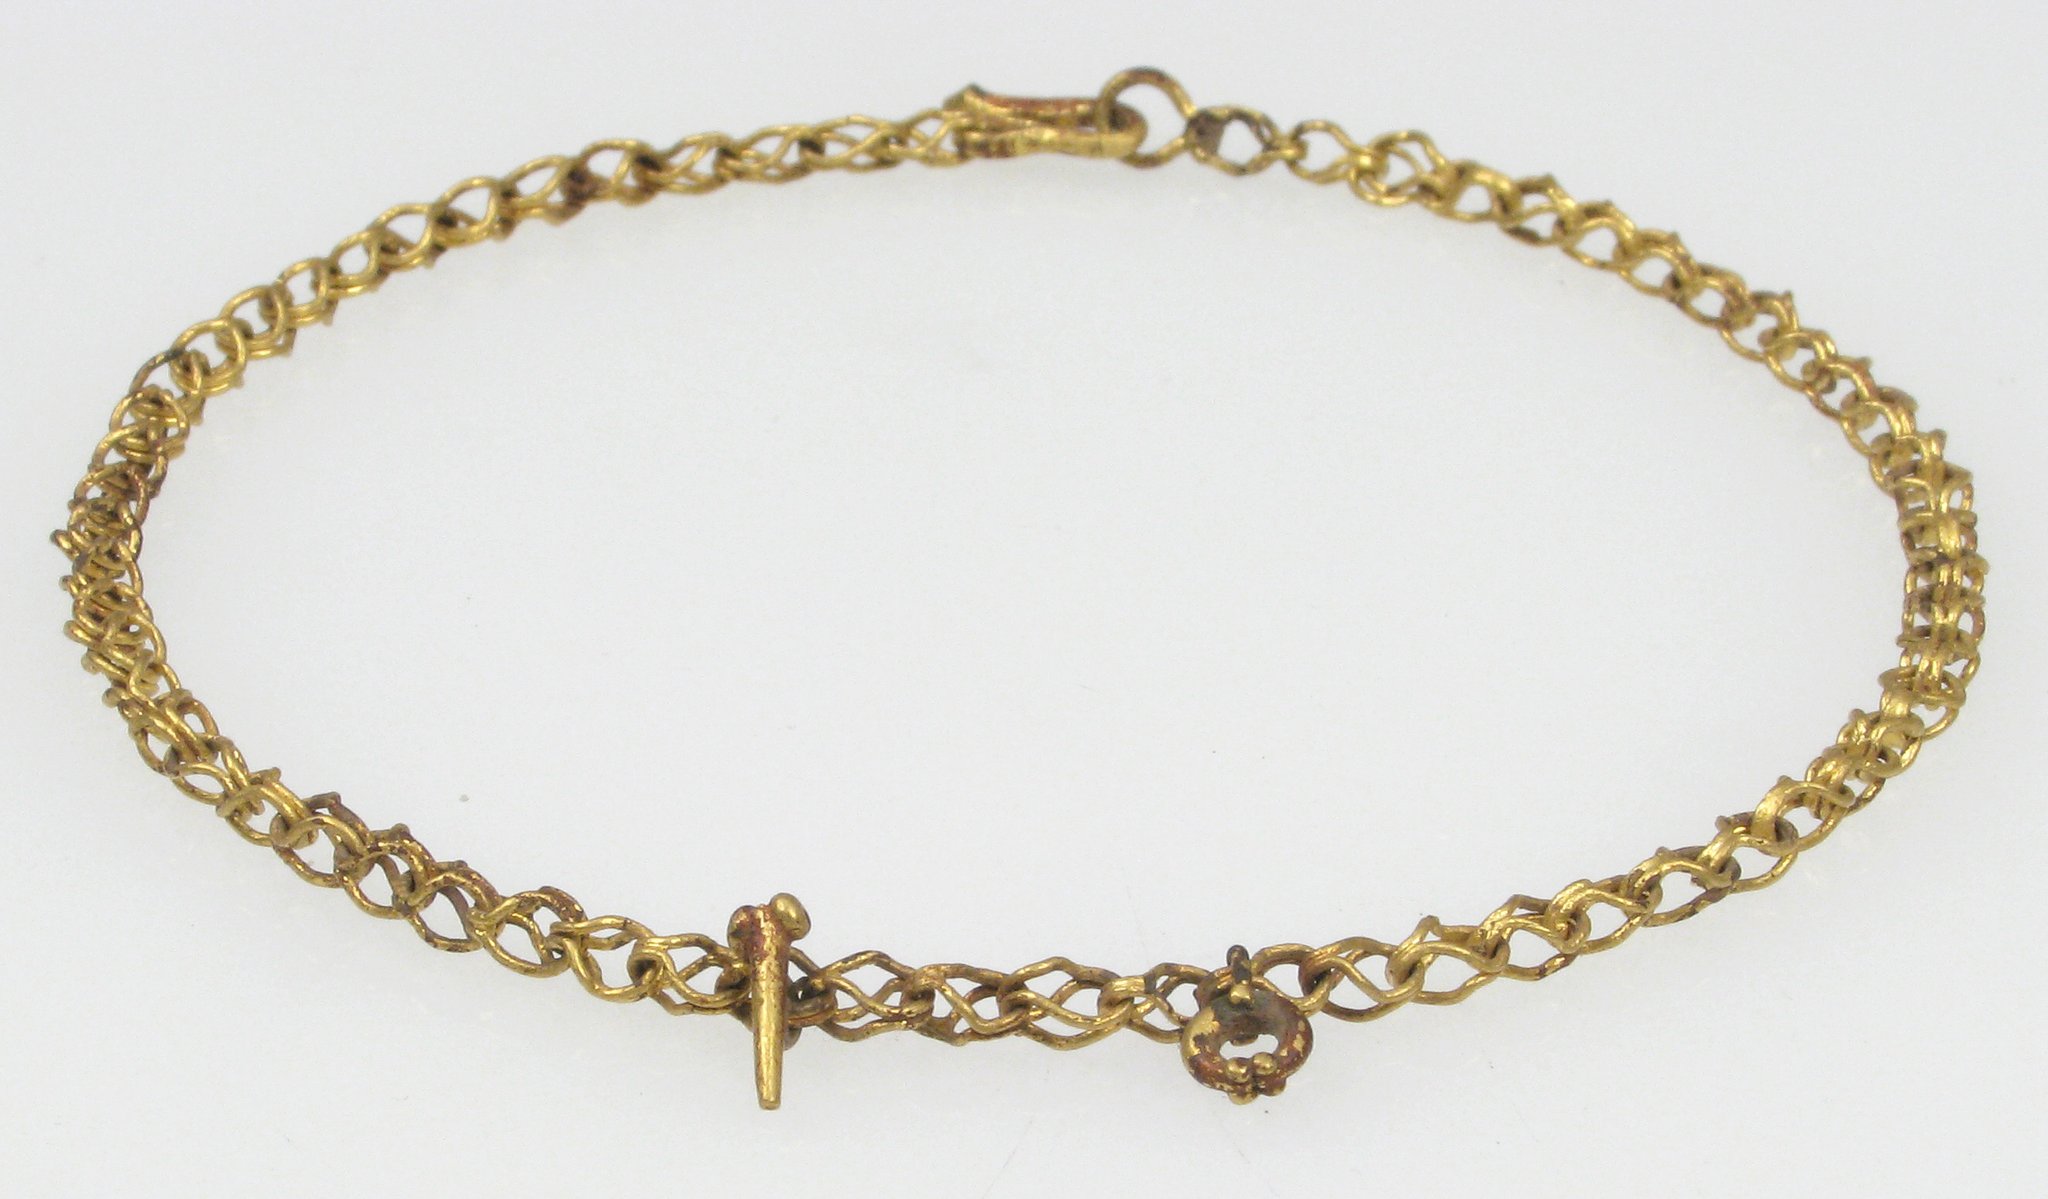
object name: chain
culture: roman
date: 201-400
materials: gold